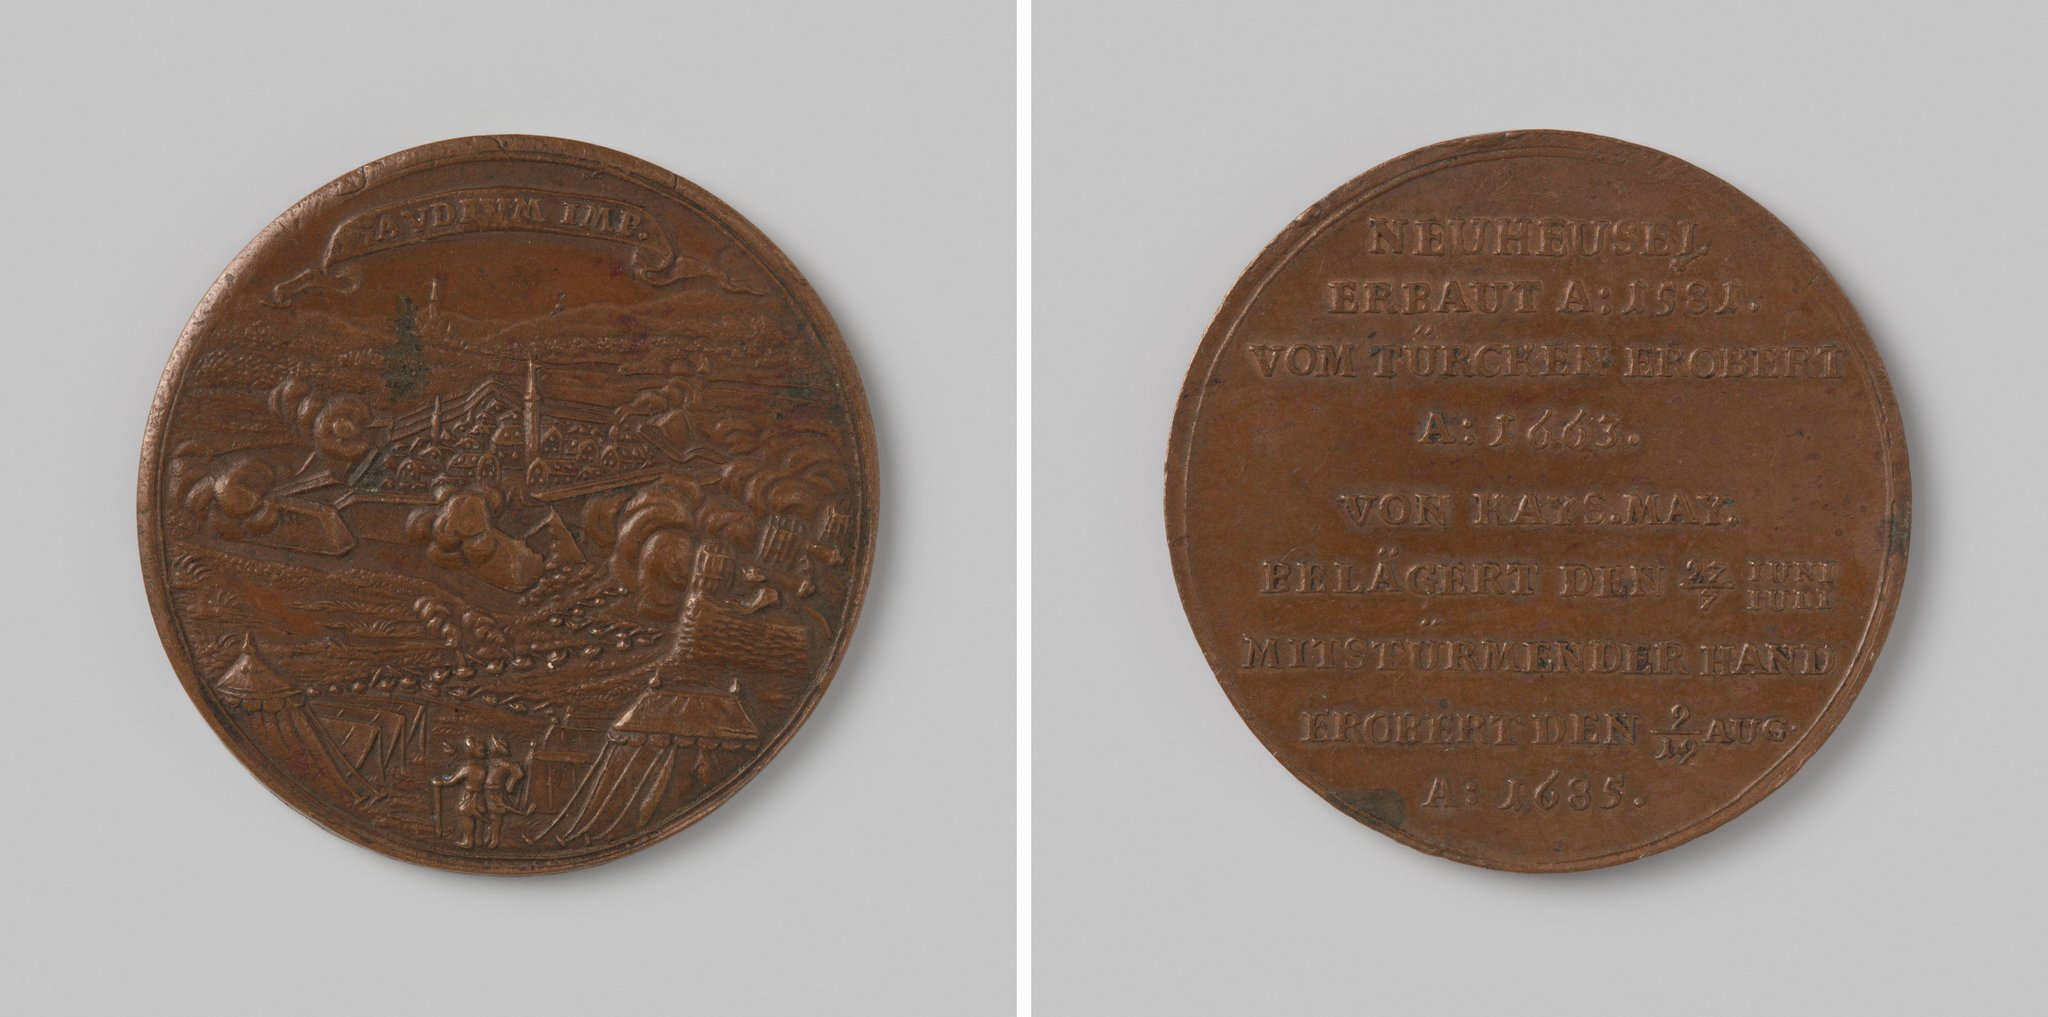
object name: history medal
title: Inname van Neuheusel door de Duitse Keizer op de Turken 1685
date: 1685-1695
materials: copper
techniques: striking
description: Koperen penning, op de voorzijde de belegering van een vesting in vogelvlucht, met bovenaan een tekstband, op de keerzijde negen regels tekst.